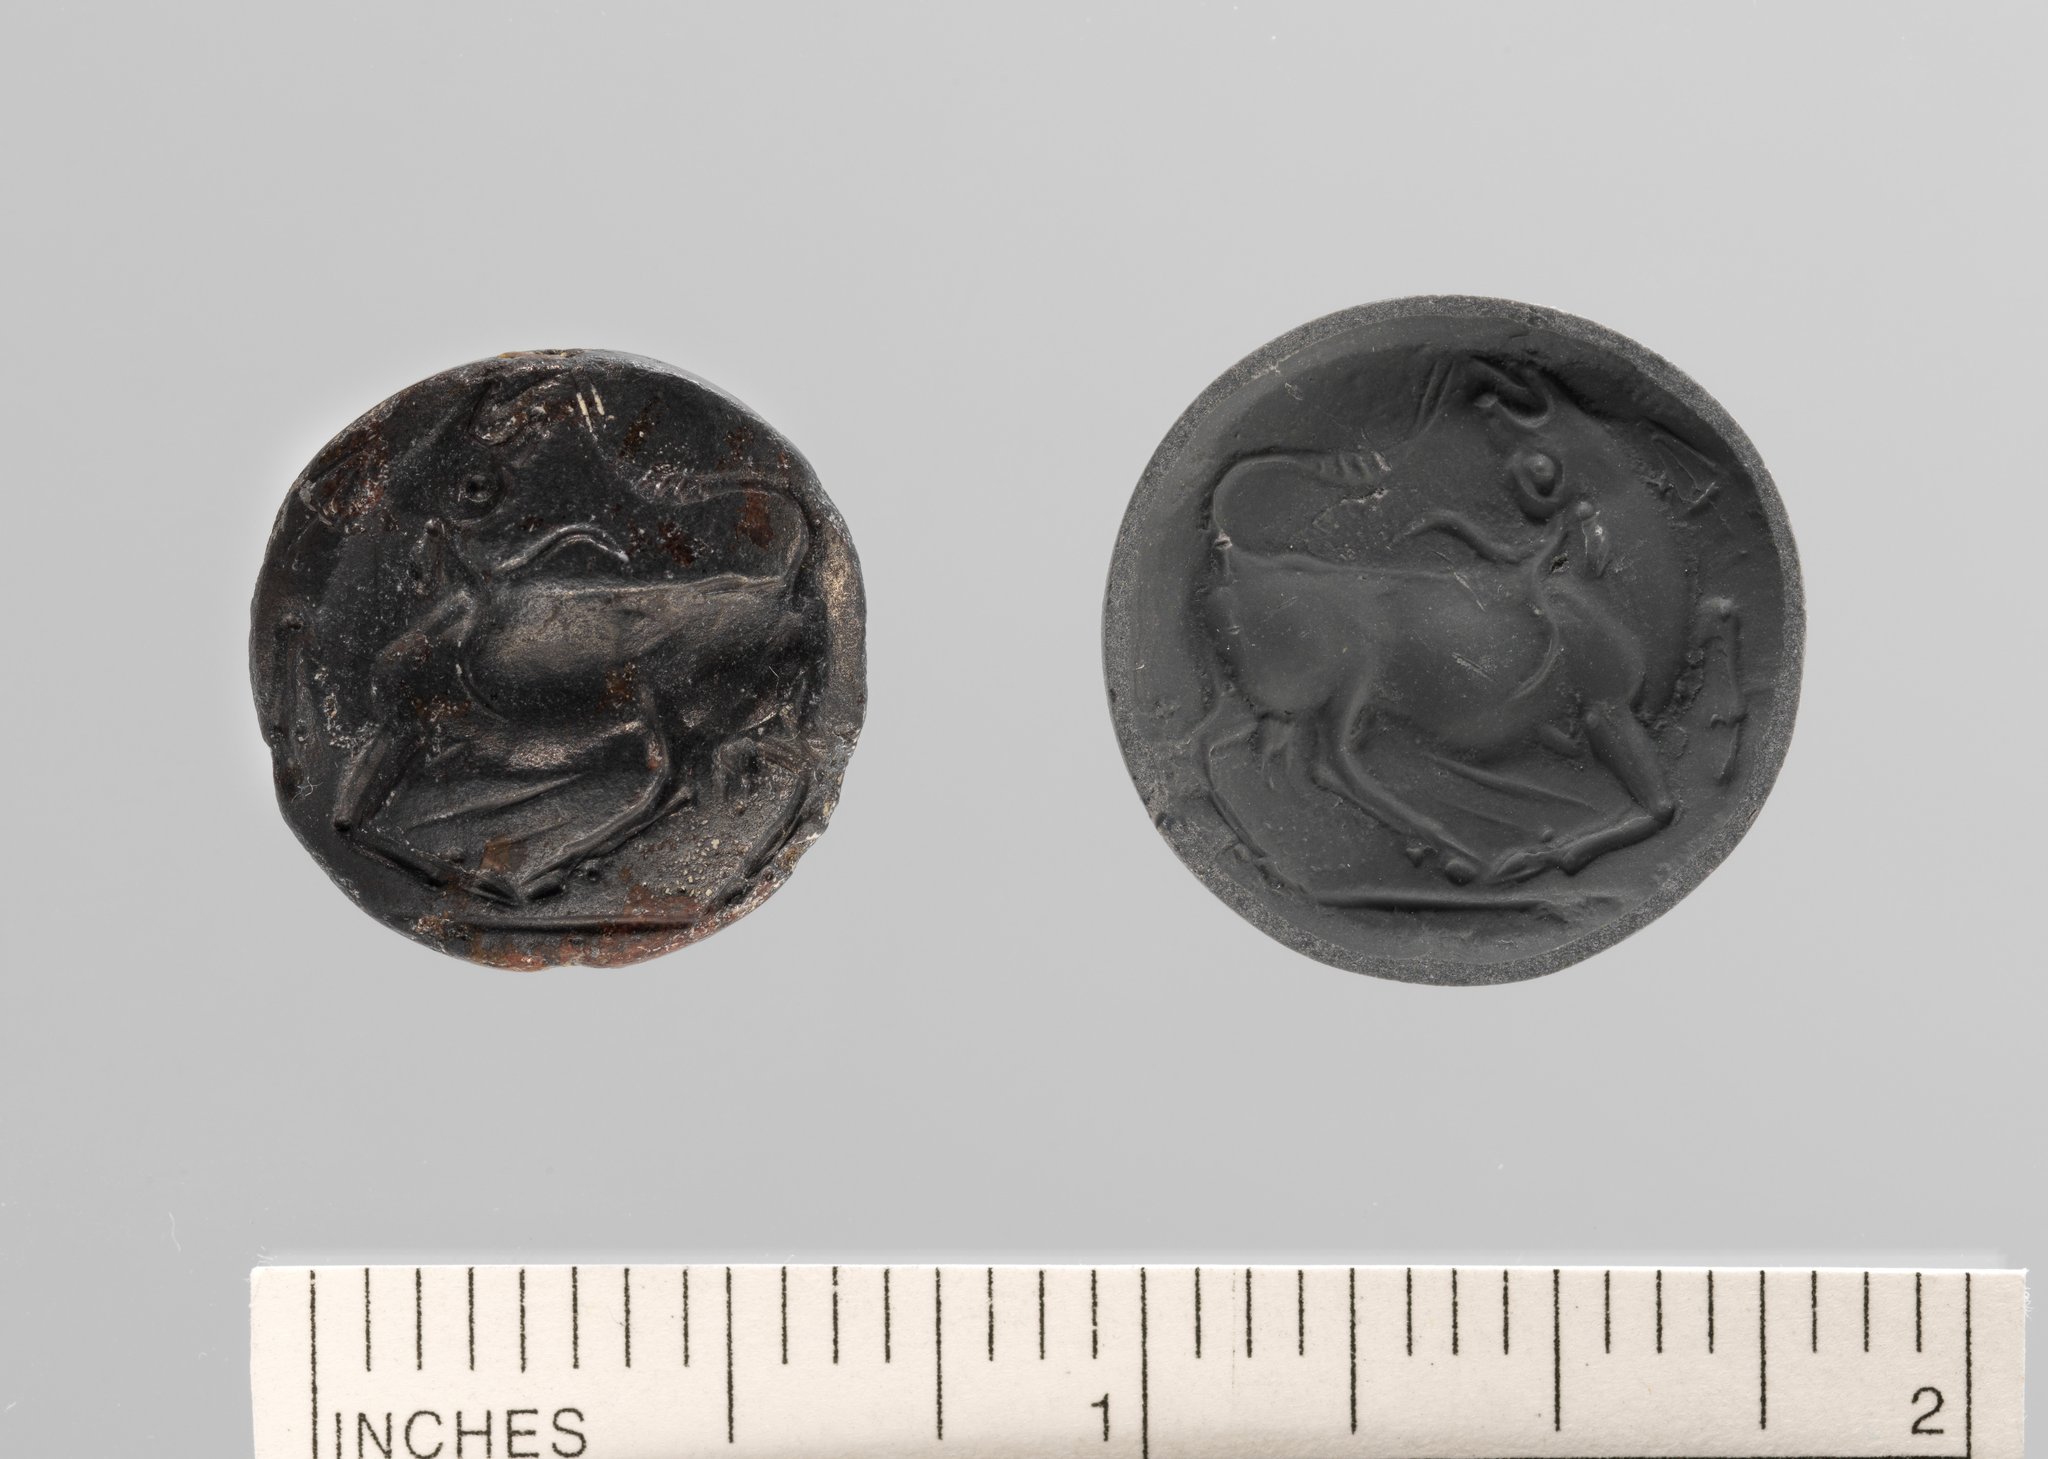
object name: seal, lentoid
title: Hematite Lentoid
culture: minoan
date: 1450-1375 BCE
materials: mineral